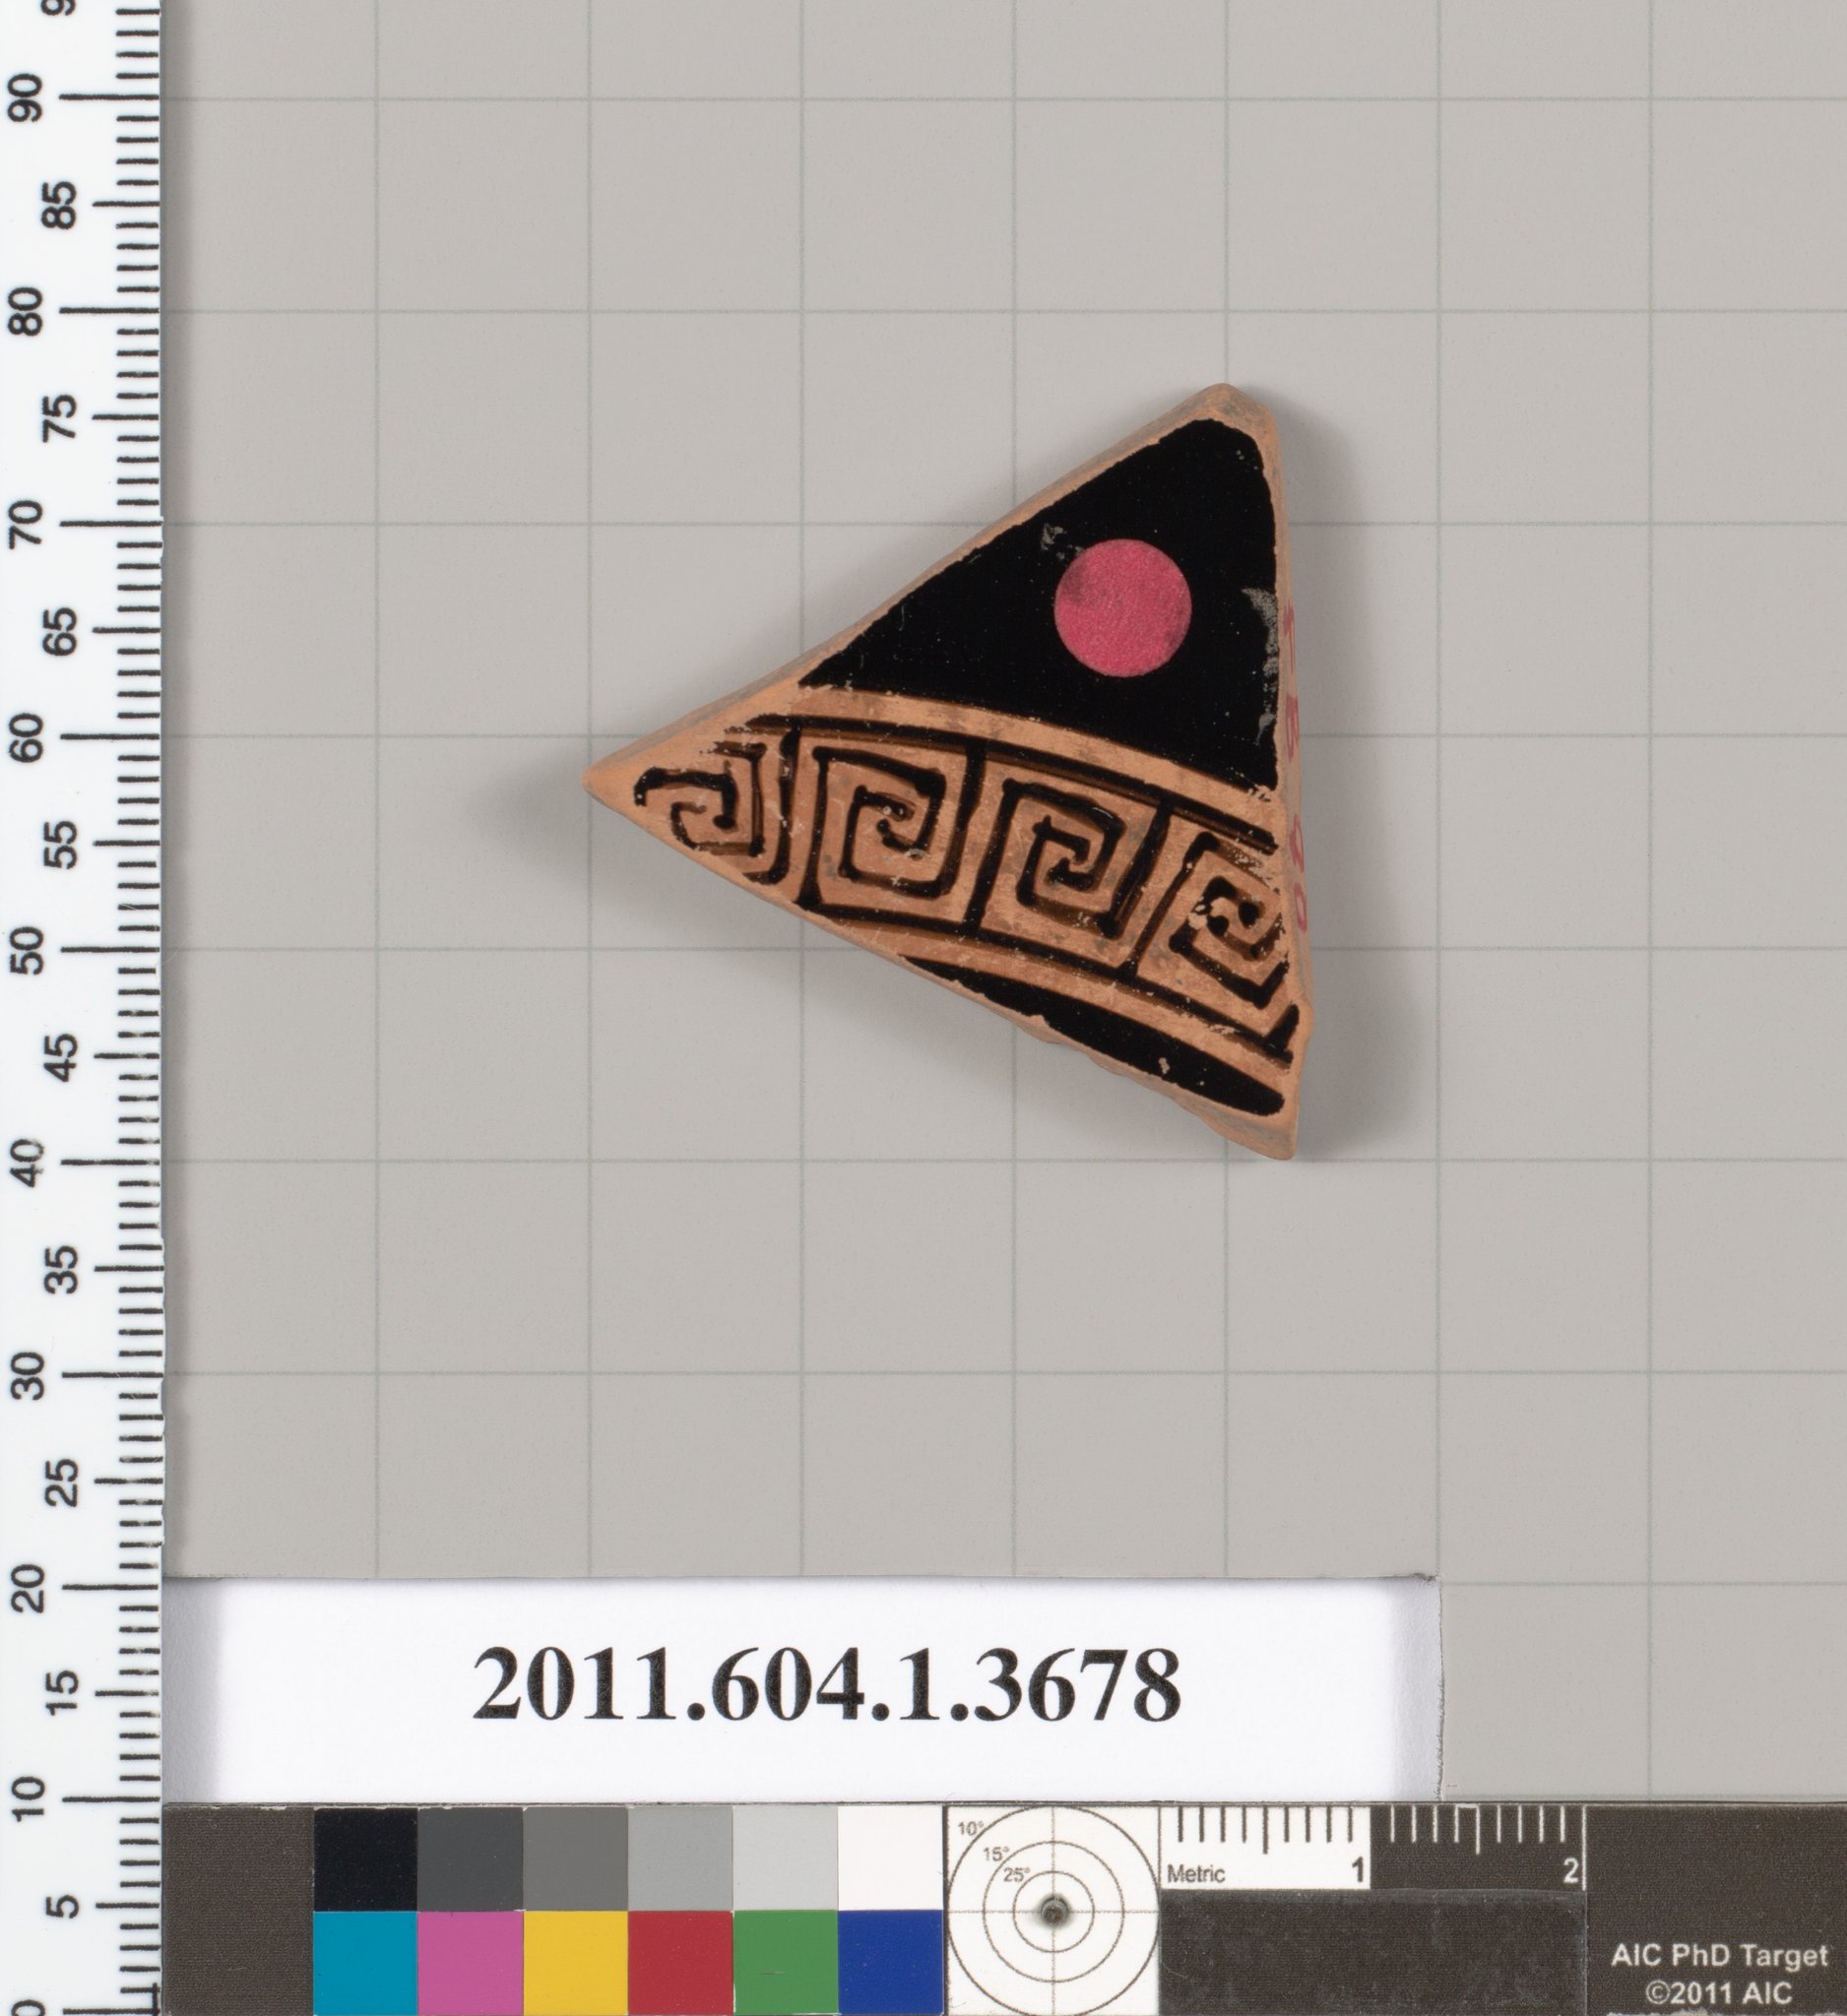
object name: kylix fragment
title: Terracotta fragment of a kylix (drinking cup)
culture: greek, attic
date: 490-480 BCE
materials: terracotta